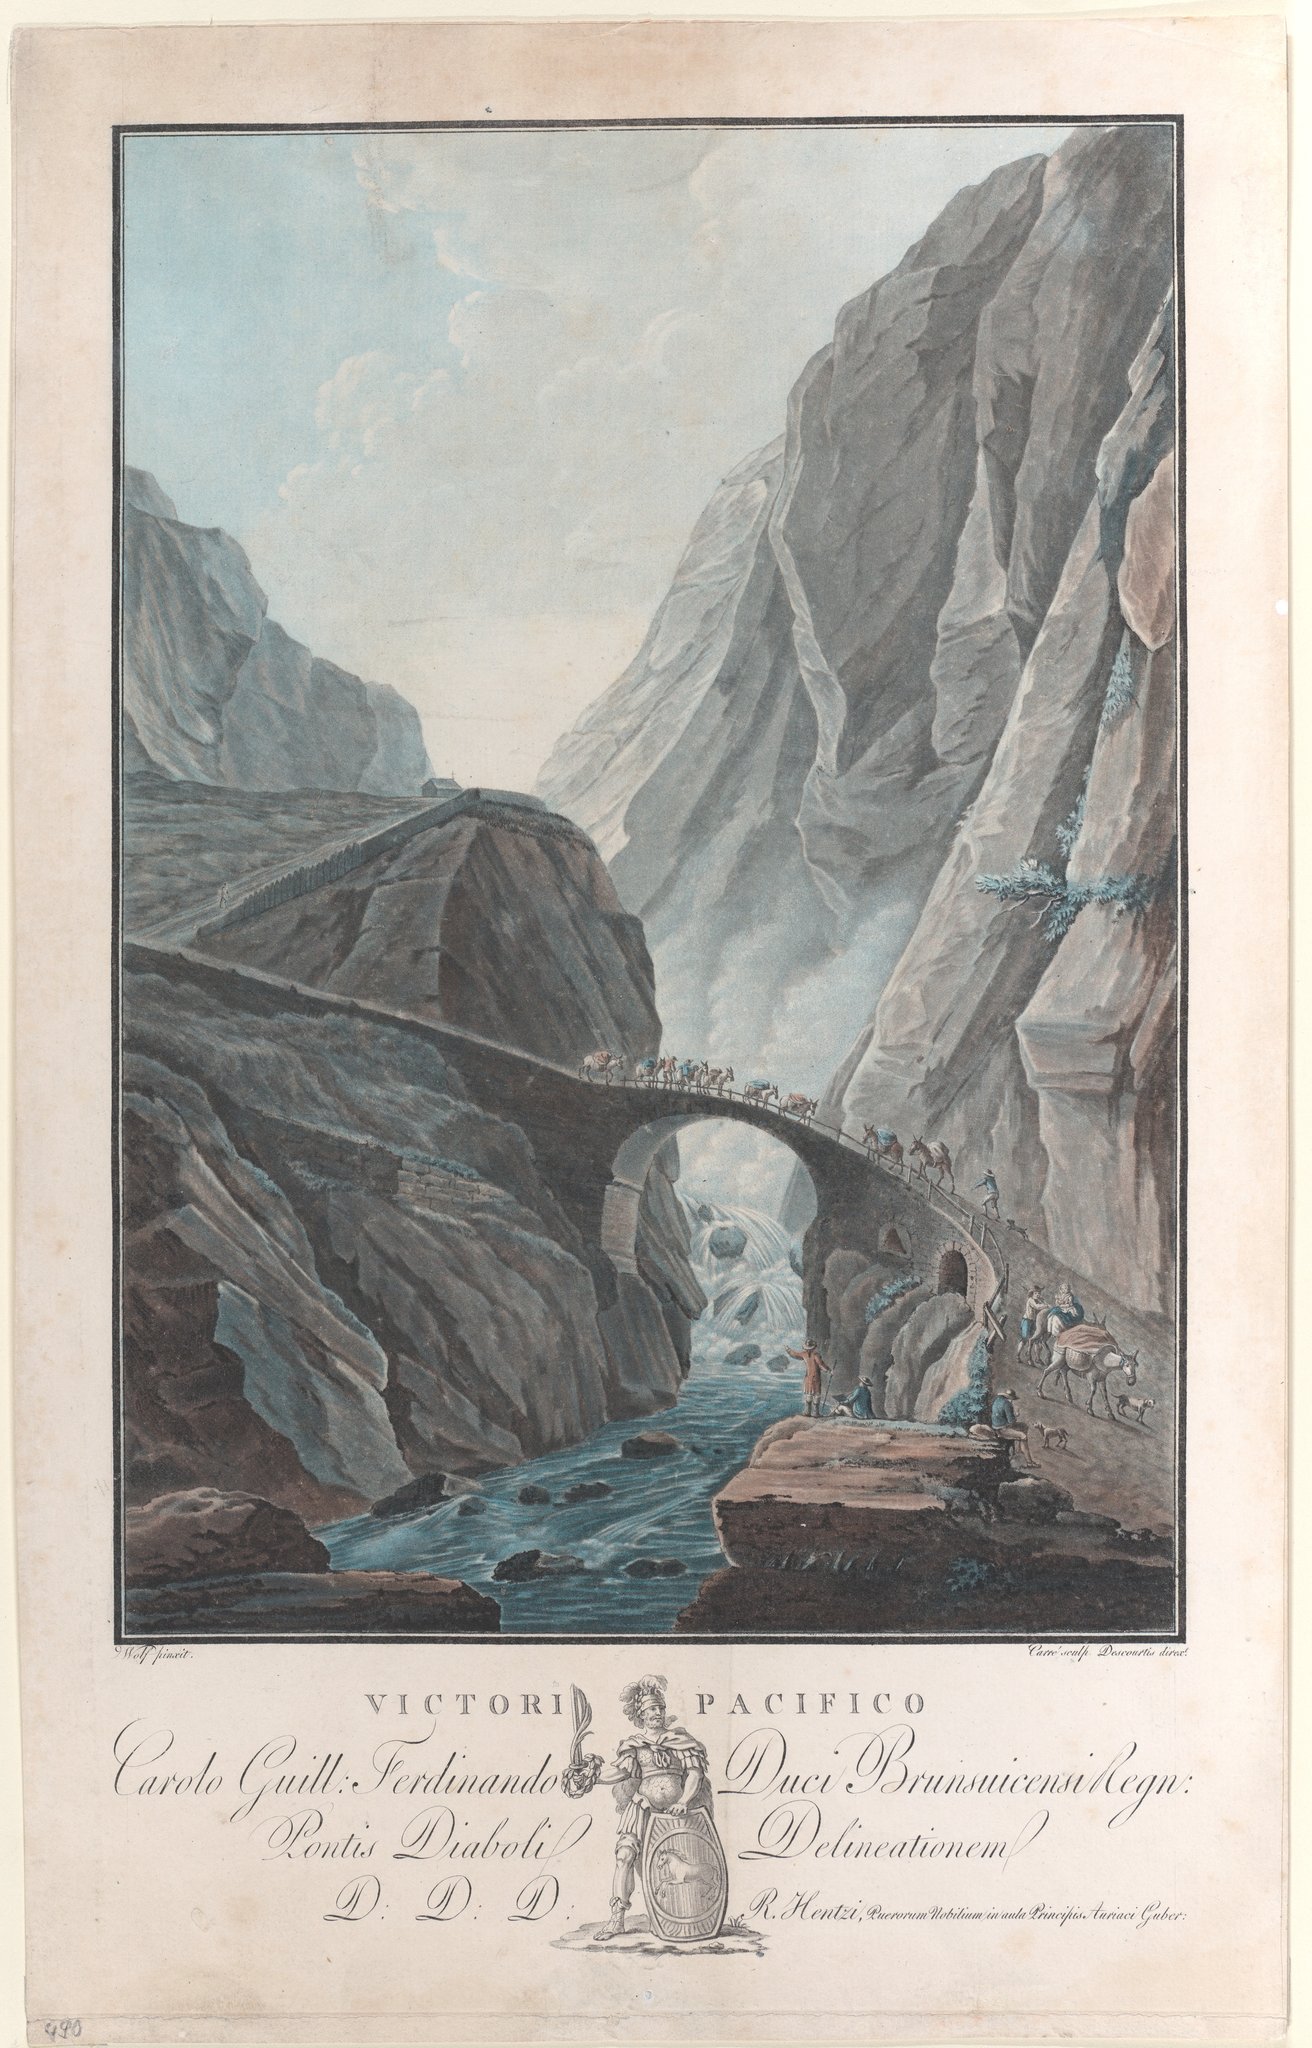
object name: print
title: Victori Pacifico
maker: charles melchior descourtis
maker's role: artist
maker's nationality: french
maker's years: 1753-1820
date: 1785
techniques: aquatint, engraving, etching